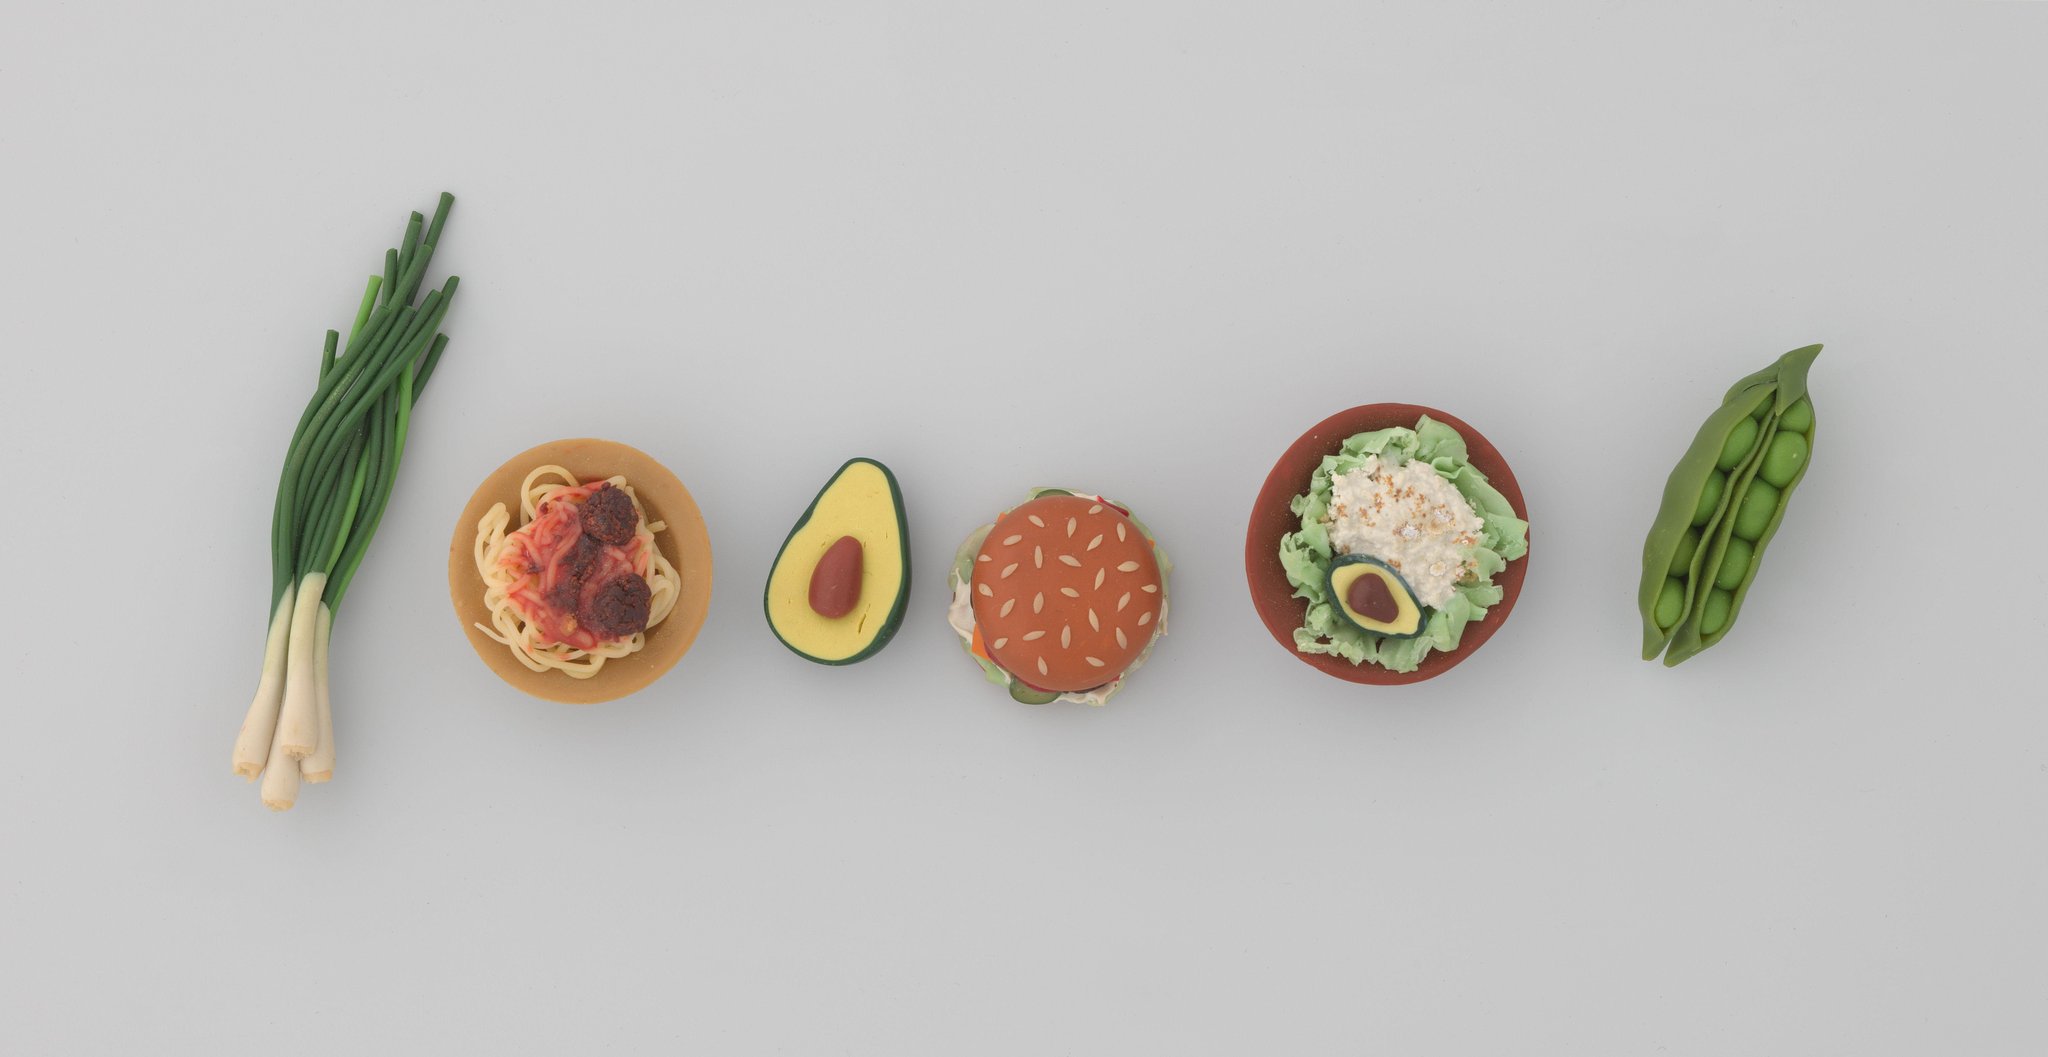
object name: brooch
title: Halve avocado met pit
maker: Anonymous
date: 1970-1980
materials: metal, plastic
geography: united states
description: De broche is voorzien van een stift met poucet.